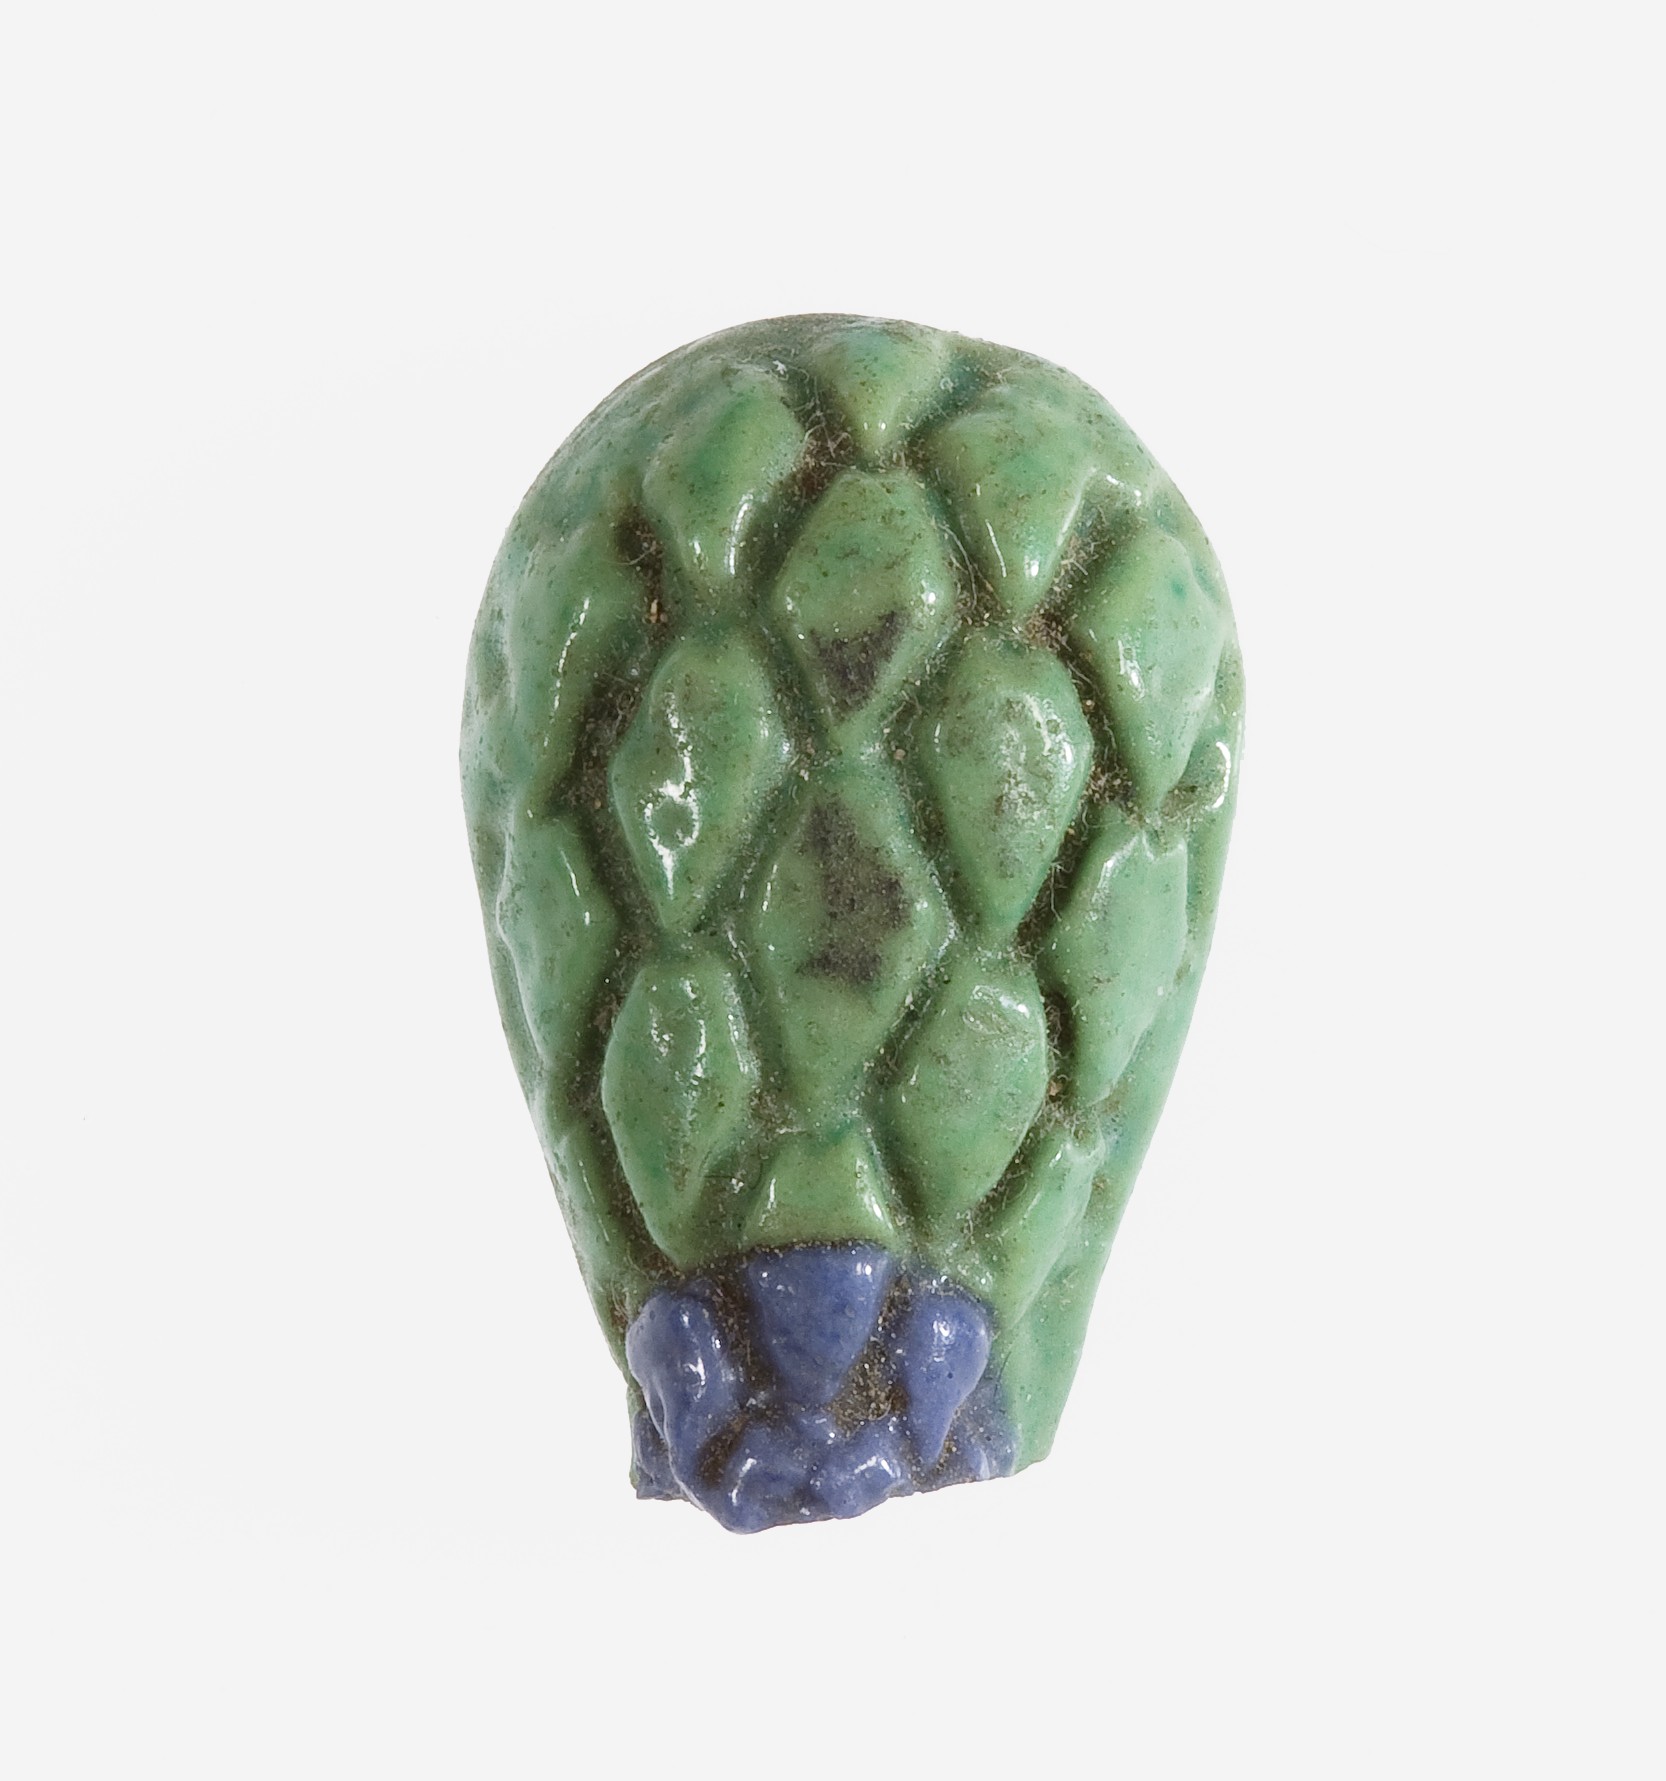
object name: pendant, cornflower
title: Cornflower Pendant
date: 1390-1352 BCE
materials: faience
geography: egypt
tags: flowers